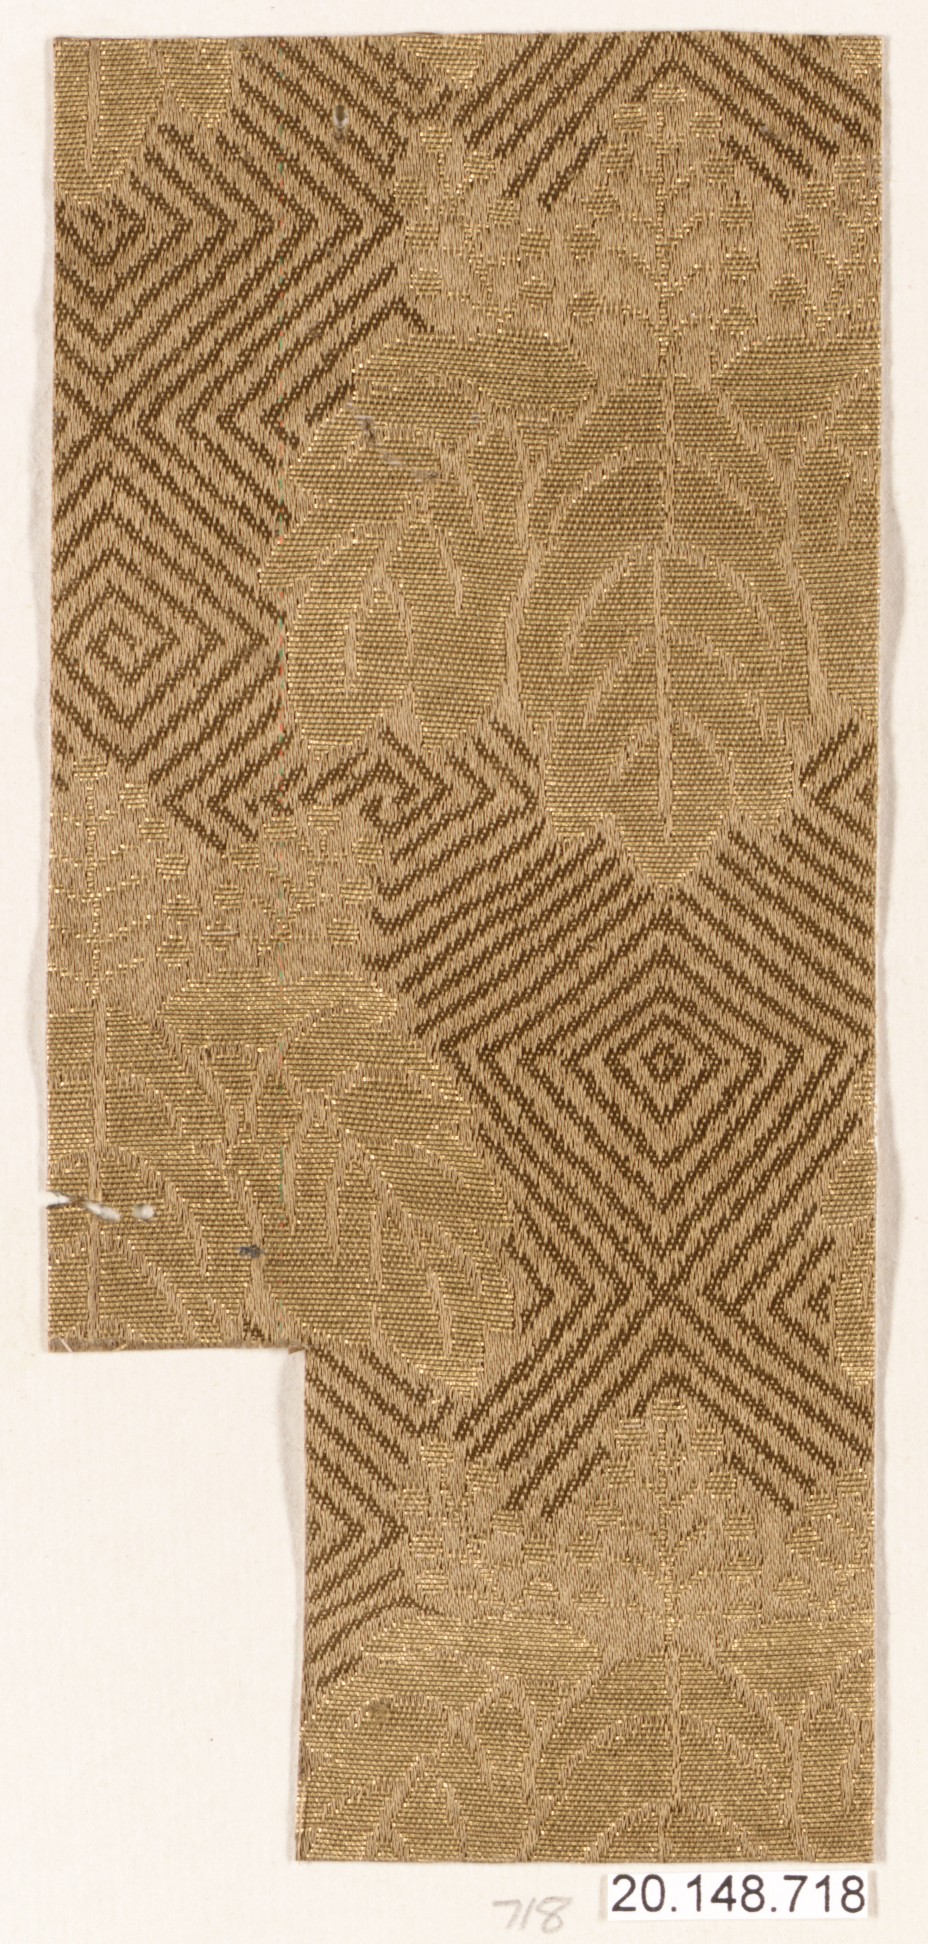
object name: piece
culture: japanese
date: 1701-1800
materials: silk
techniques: compound weave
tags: leaves